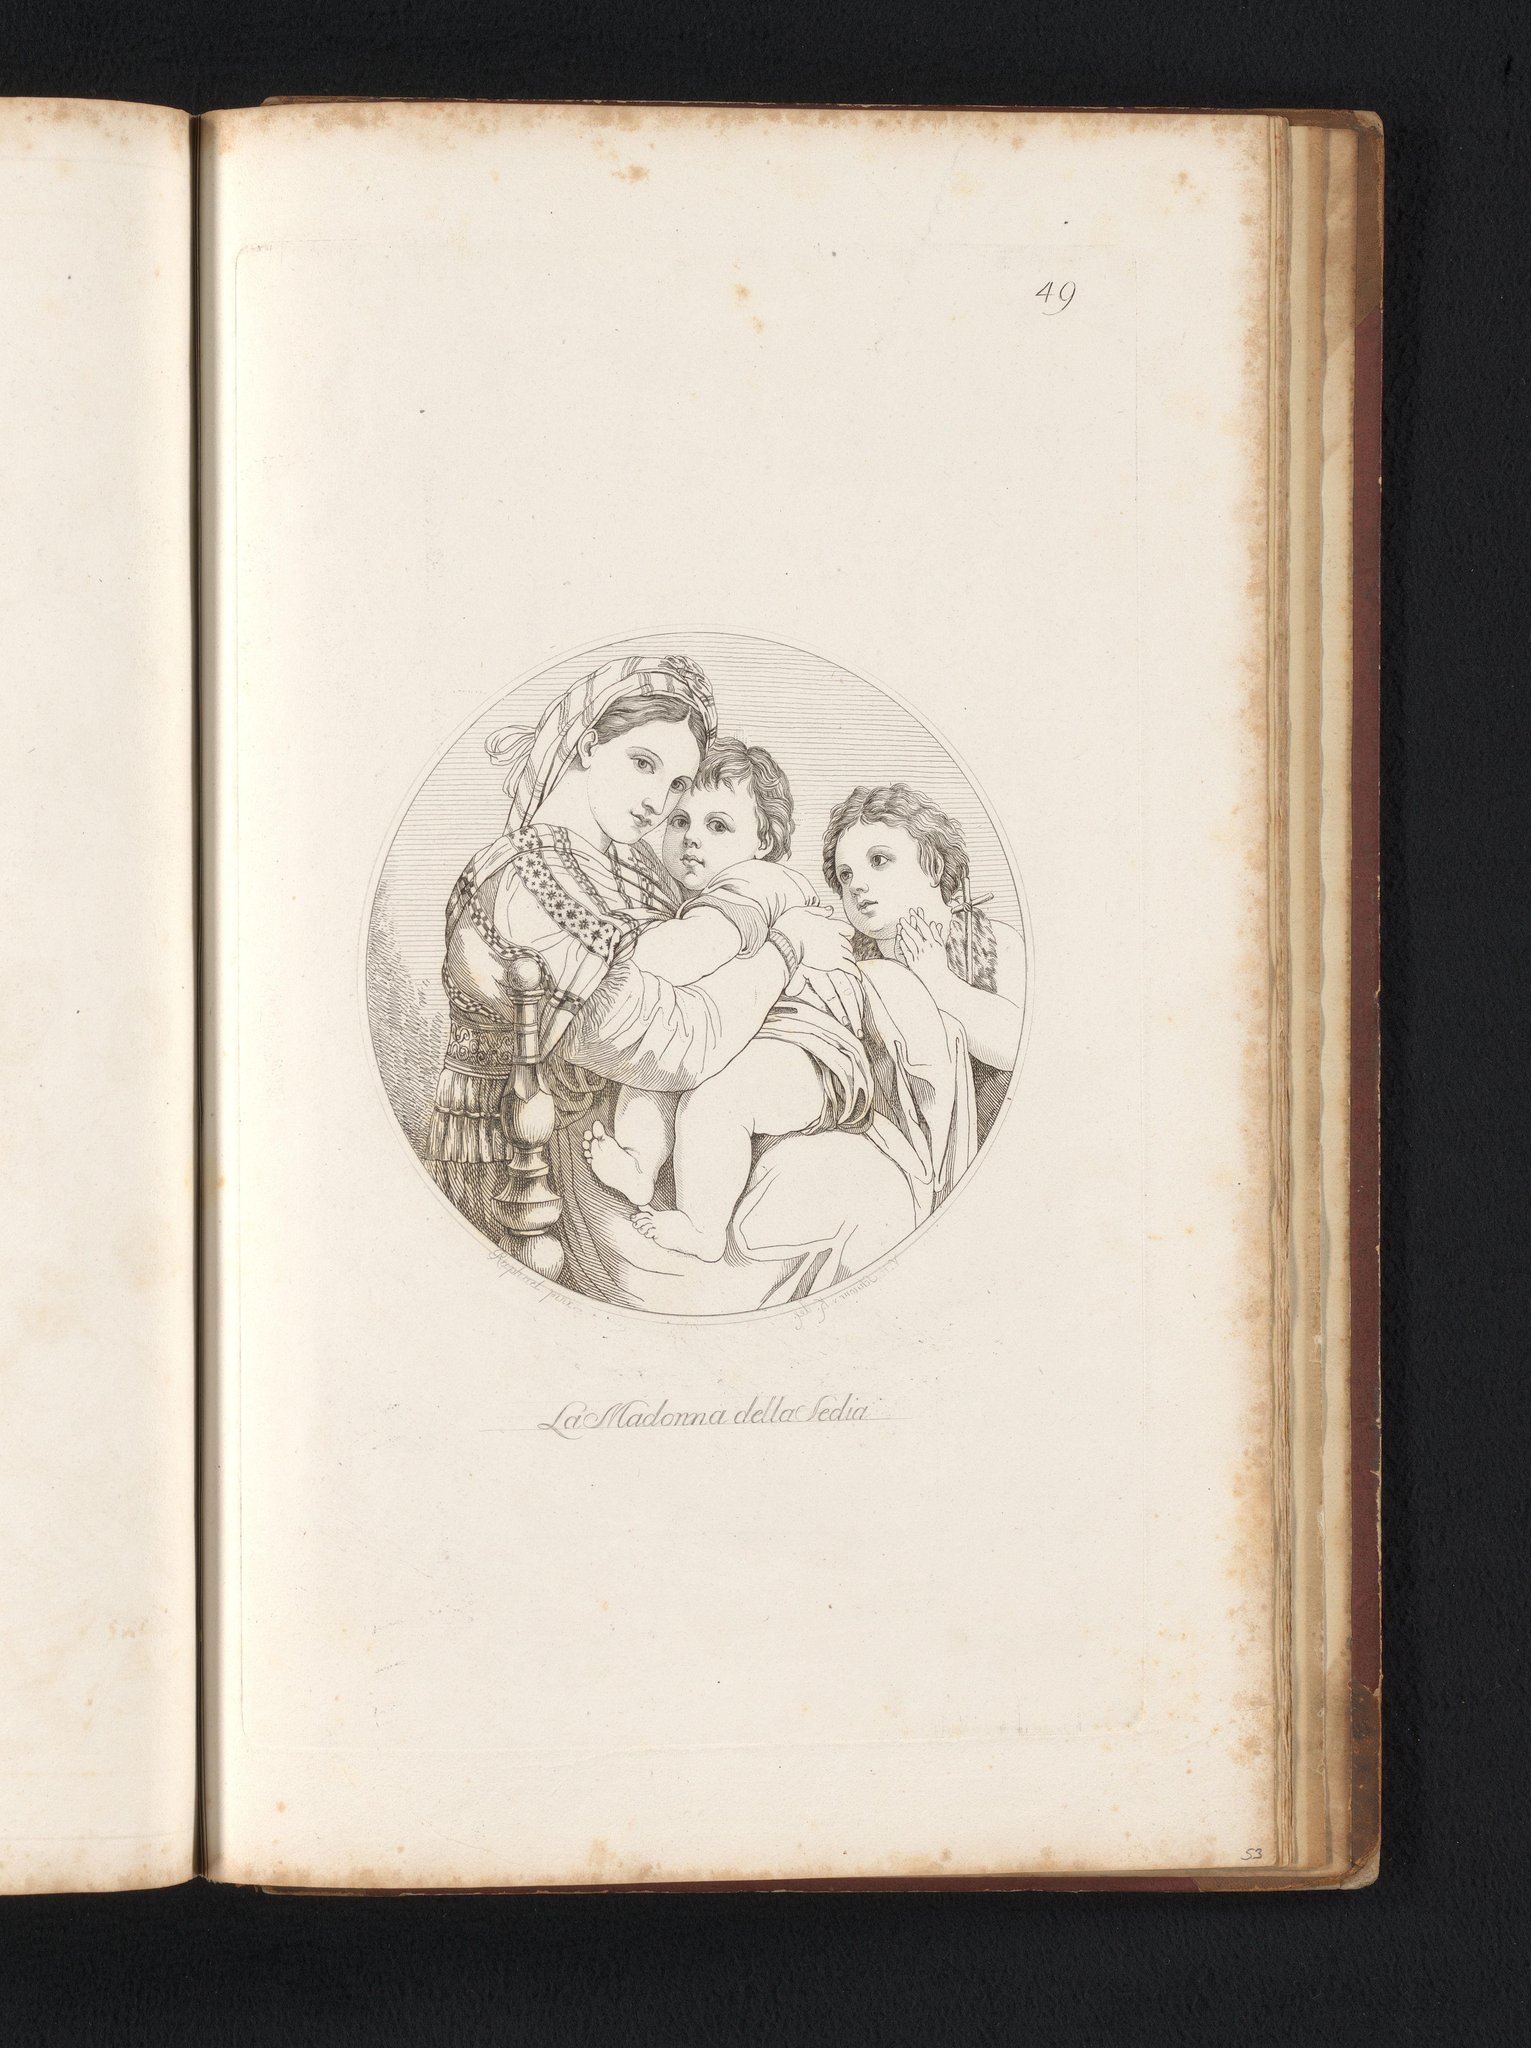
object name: print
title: La Madonna della sedia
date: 1750-1816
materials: paper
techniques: etching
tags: mary and the christ-child with john the baptist (as child)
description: Ingeplakte prent naar Rafaëls schilderij van de Madonna met stoel. Genummerd rechtsboven: 49. Onderdeel van het tweede van twee albums met ingeplakte prenten en tekeningen te dienen als tekenvoorbeelden.